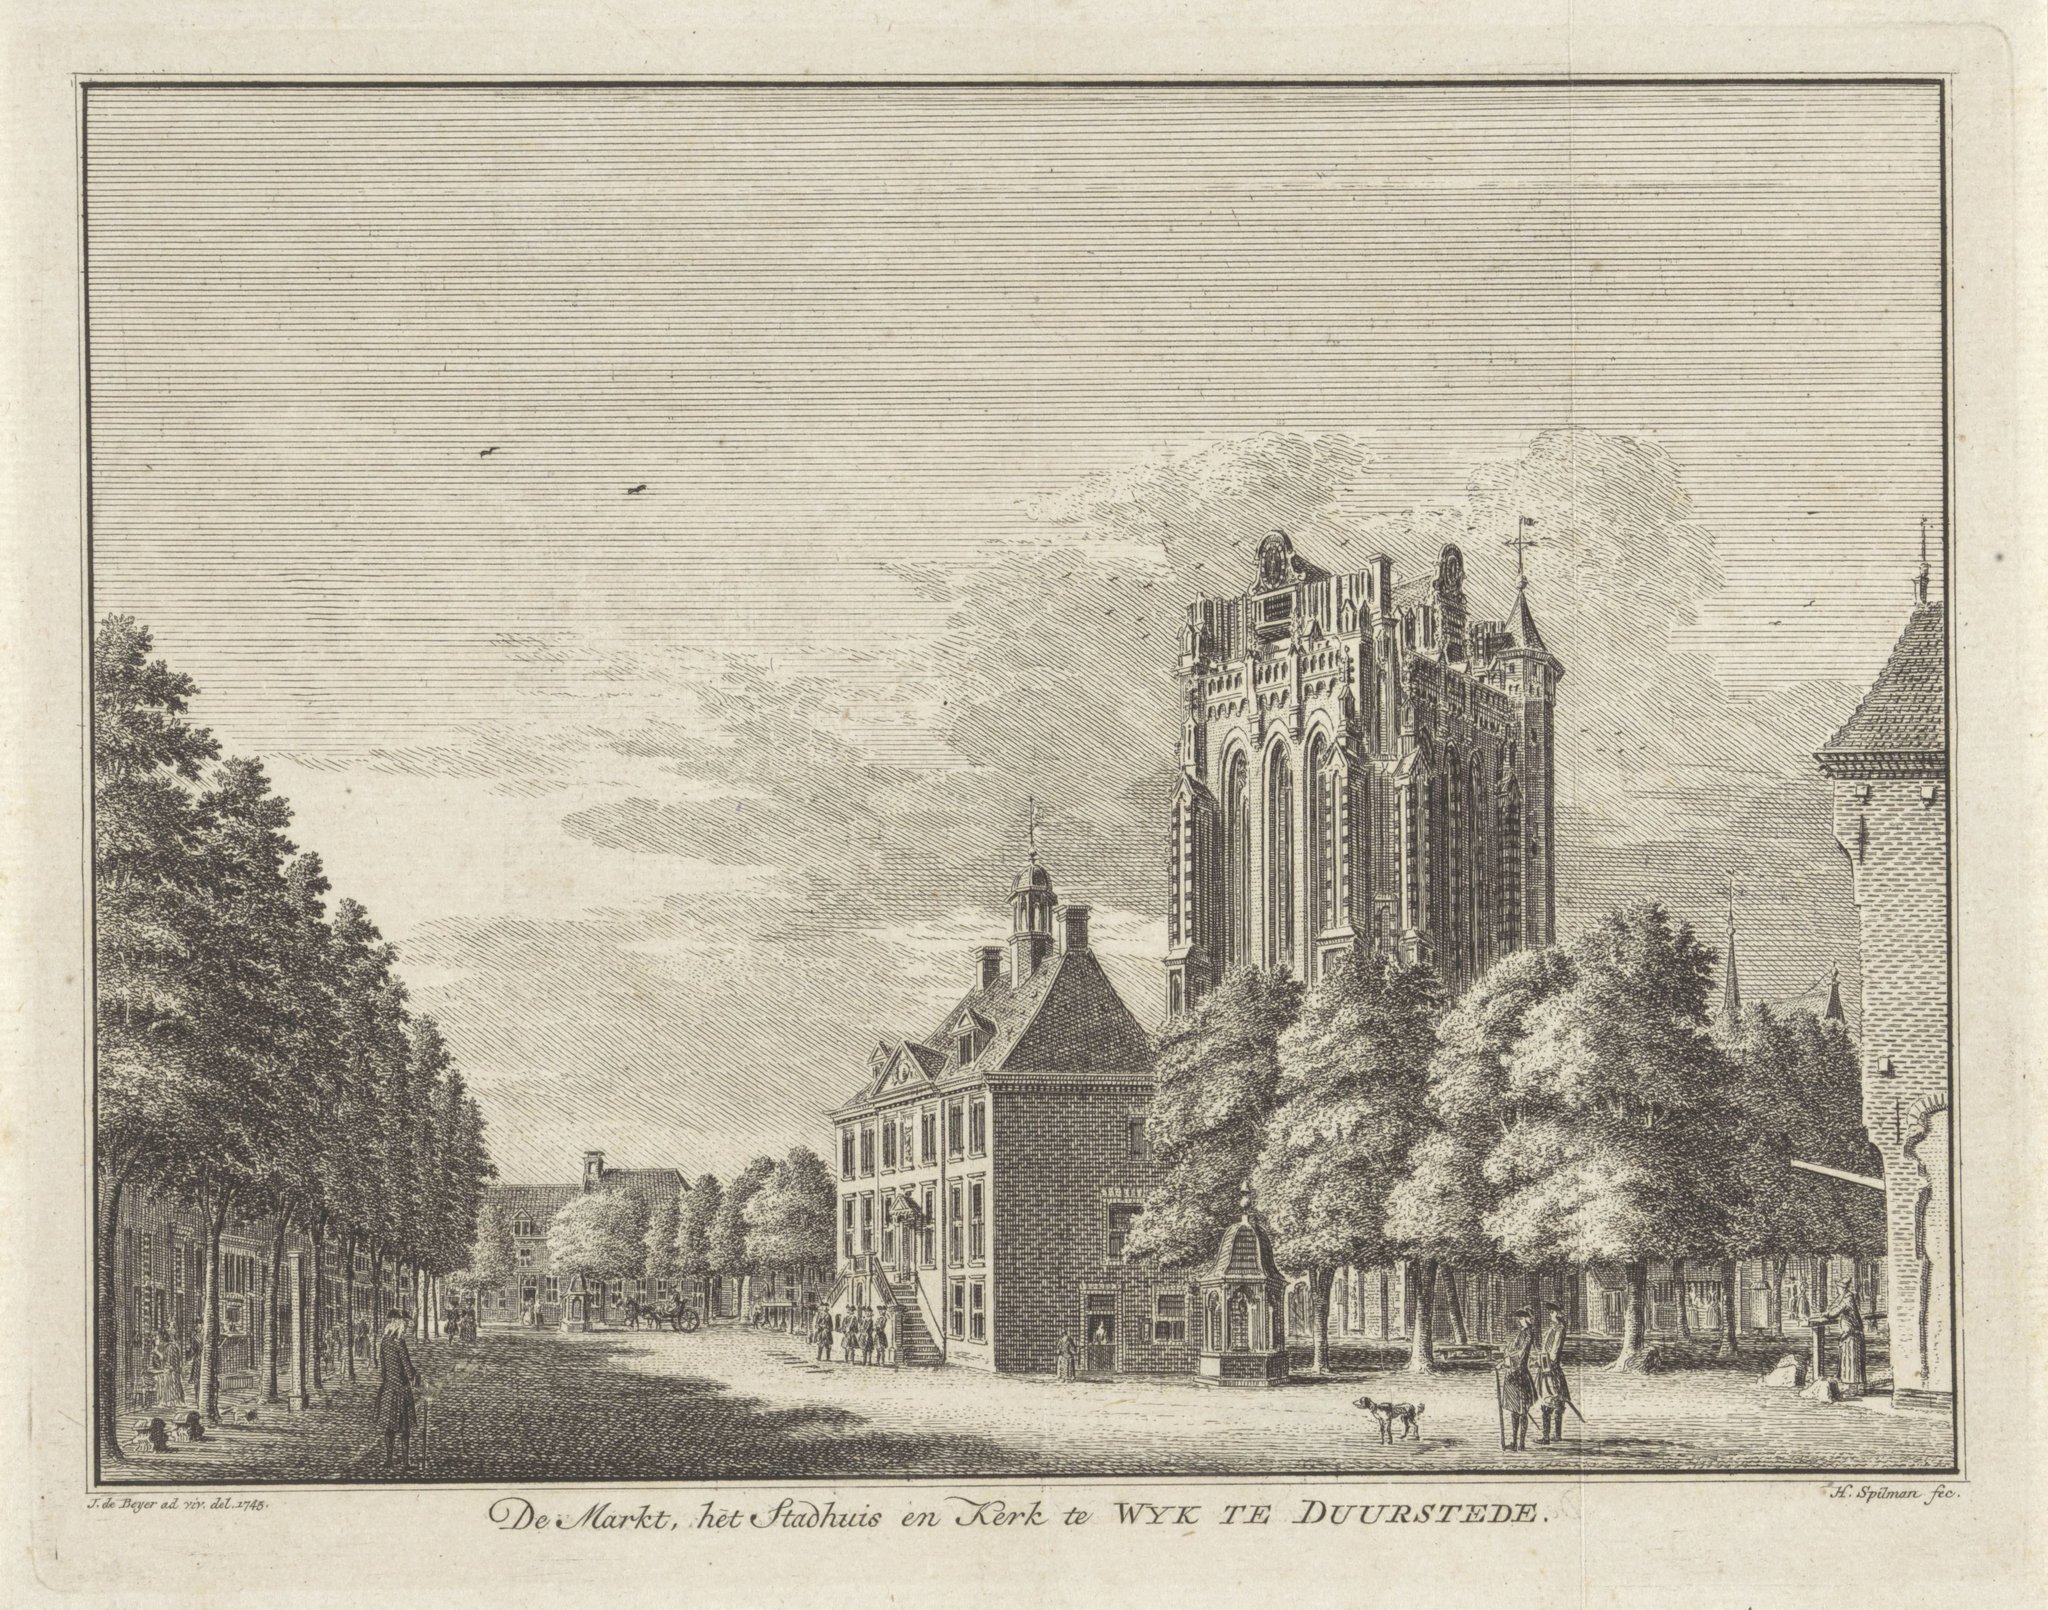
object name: print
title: Gezicht op de markt te Wijk bij Duurstede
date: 1745-1772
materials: paper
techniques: engraving, etching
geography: haarlem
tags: townhall, public road in village (+ city(-scape) with figures, staffage), parts of church exterior and annexes: tower, wijk bij duurstede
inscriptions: collector's mark: Lugt 2228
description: Prent ook gebruikt in: Tegenwoordige staat der Vereenigde Nederlanden, twaalfde deel, vervolgende de beschryving van de provincie van Utrecht. Met landkaarten, en printverbeeldingen versierd / Hedendaagsche historie, of tegenwoordige staat van alle volkeren; XXII. deel (…). Amsterdam: weduwe Isaac Tirion, 1772, tussen p. 92 en p. 93.